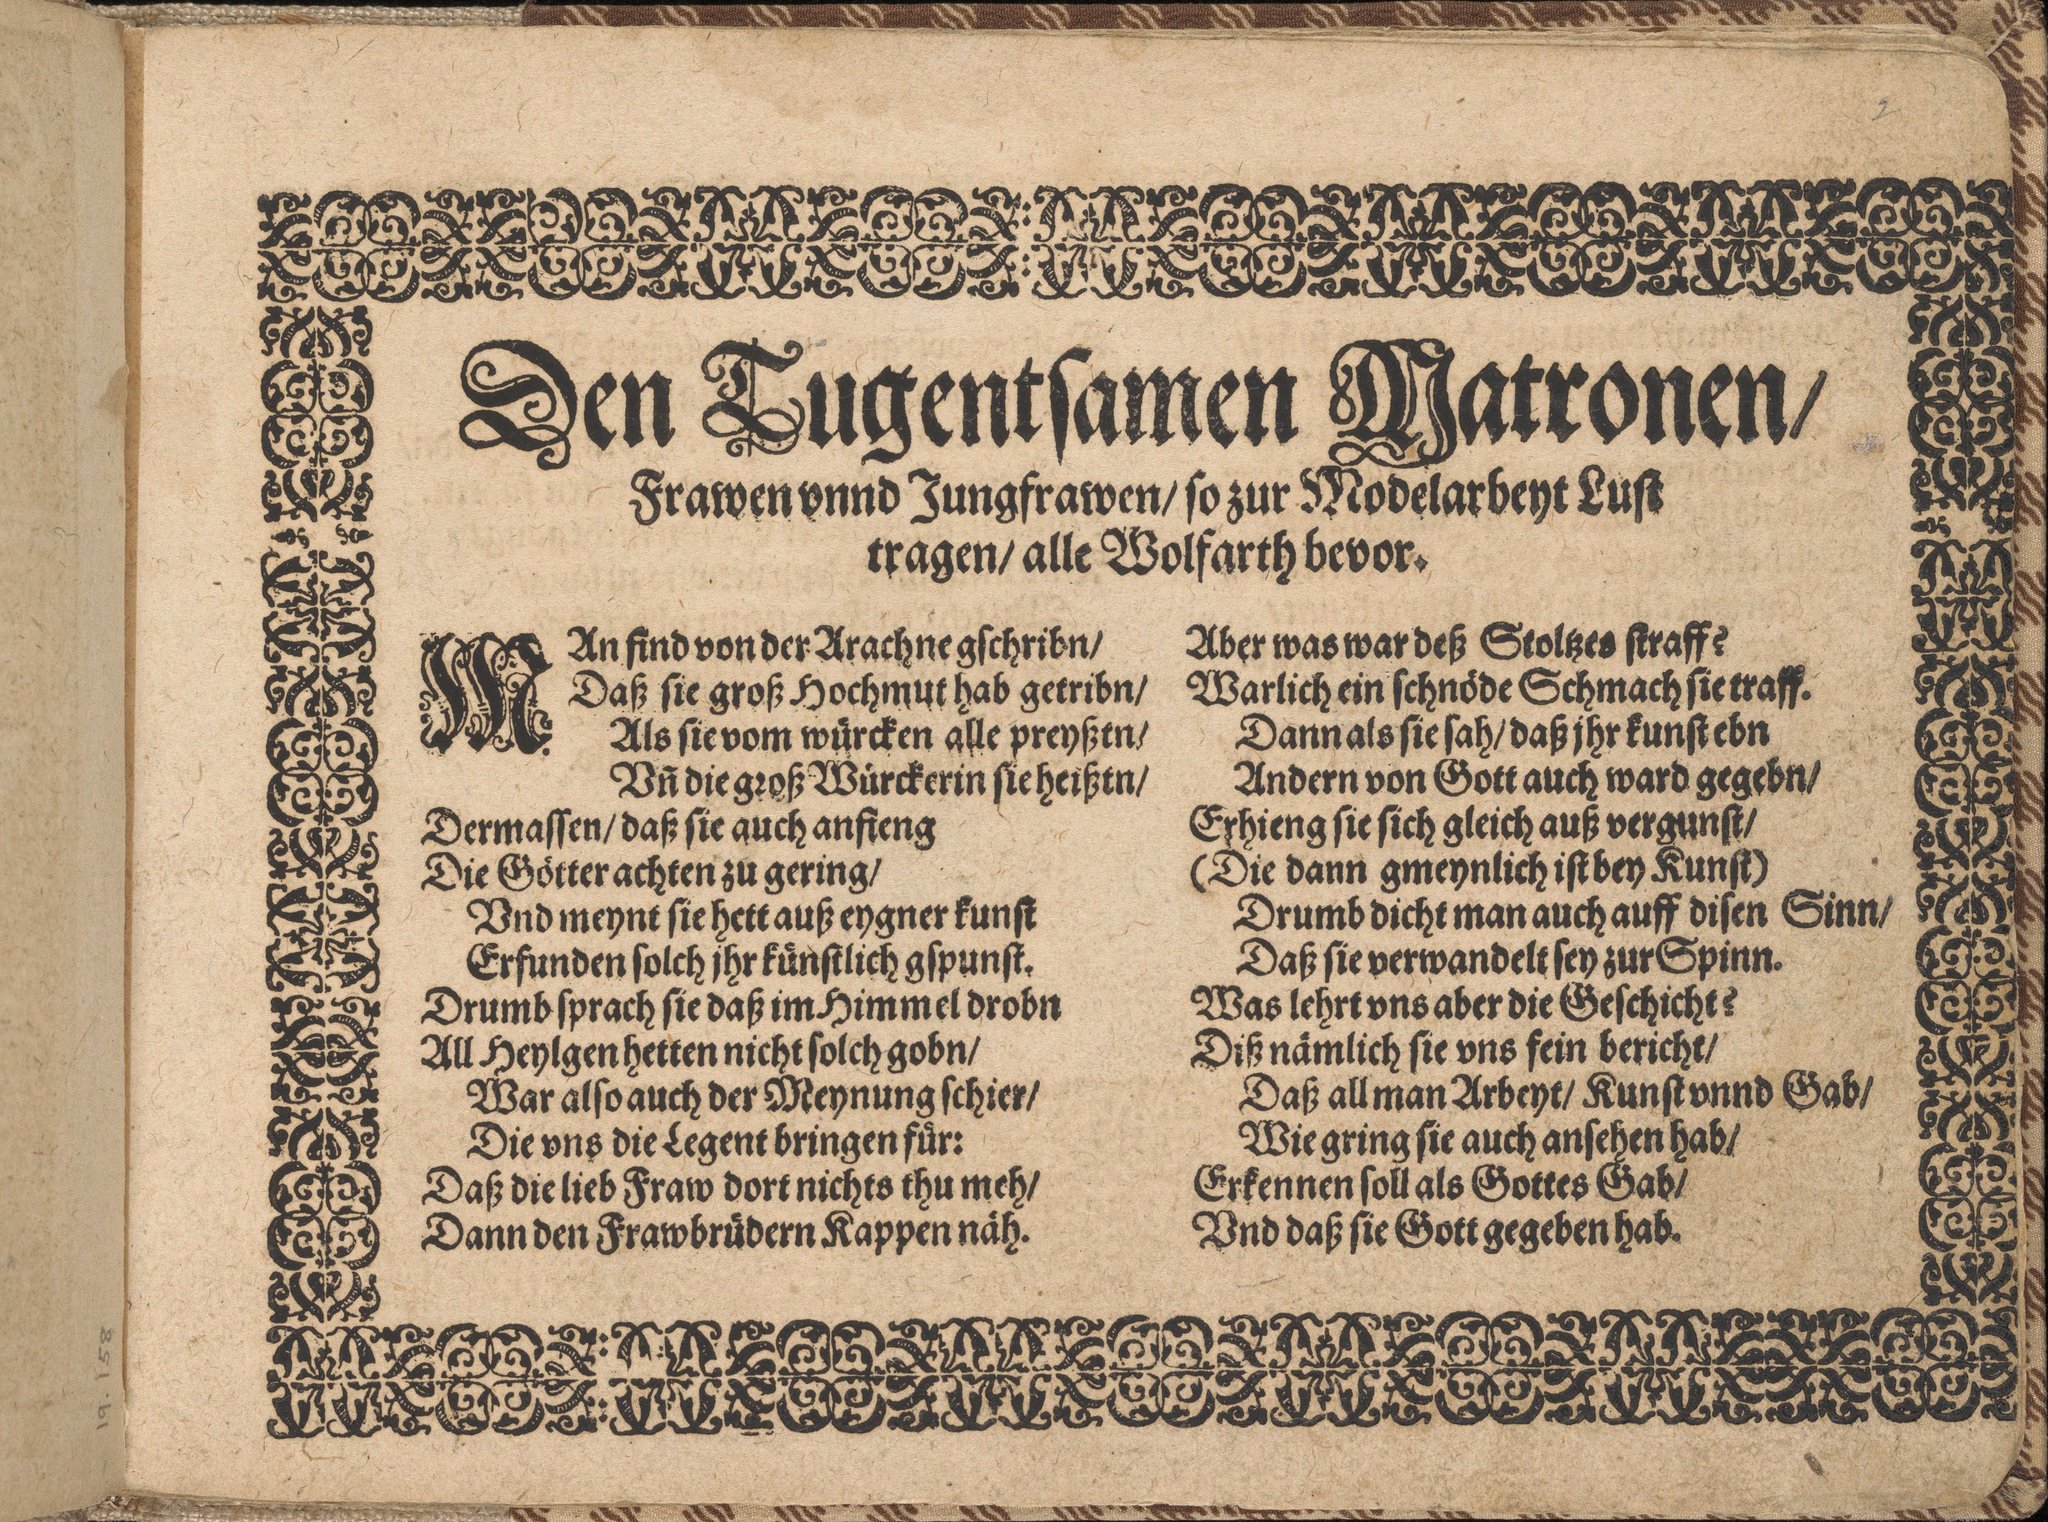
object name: book print ornament architecture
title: New Künstlichs Modelbuch (Page 2 recto)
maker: bernhard jobin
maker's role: publisher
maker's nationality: swiss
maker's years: 1535-1597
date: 1600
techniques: woodcut